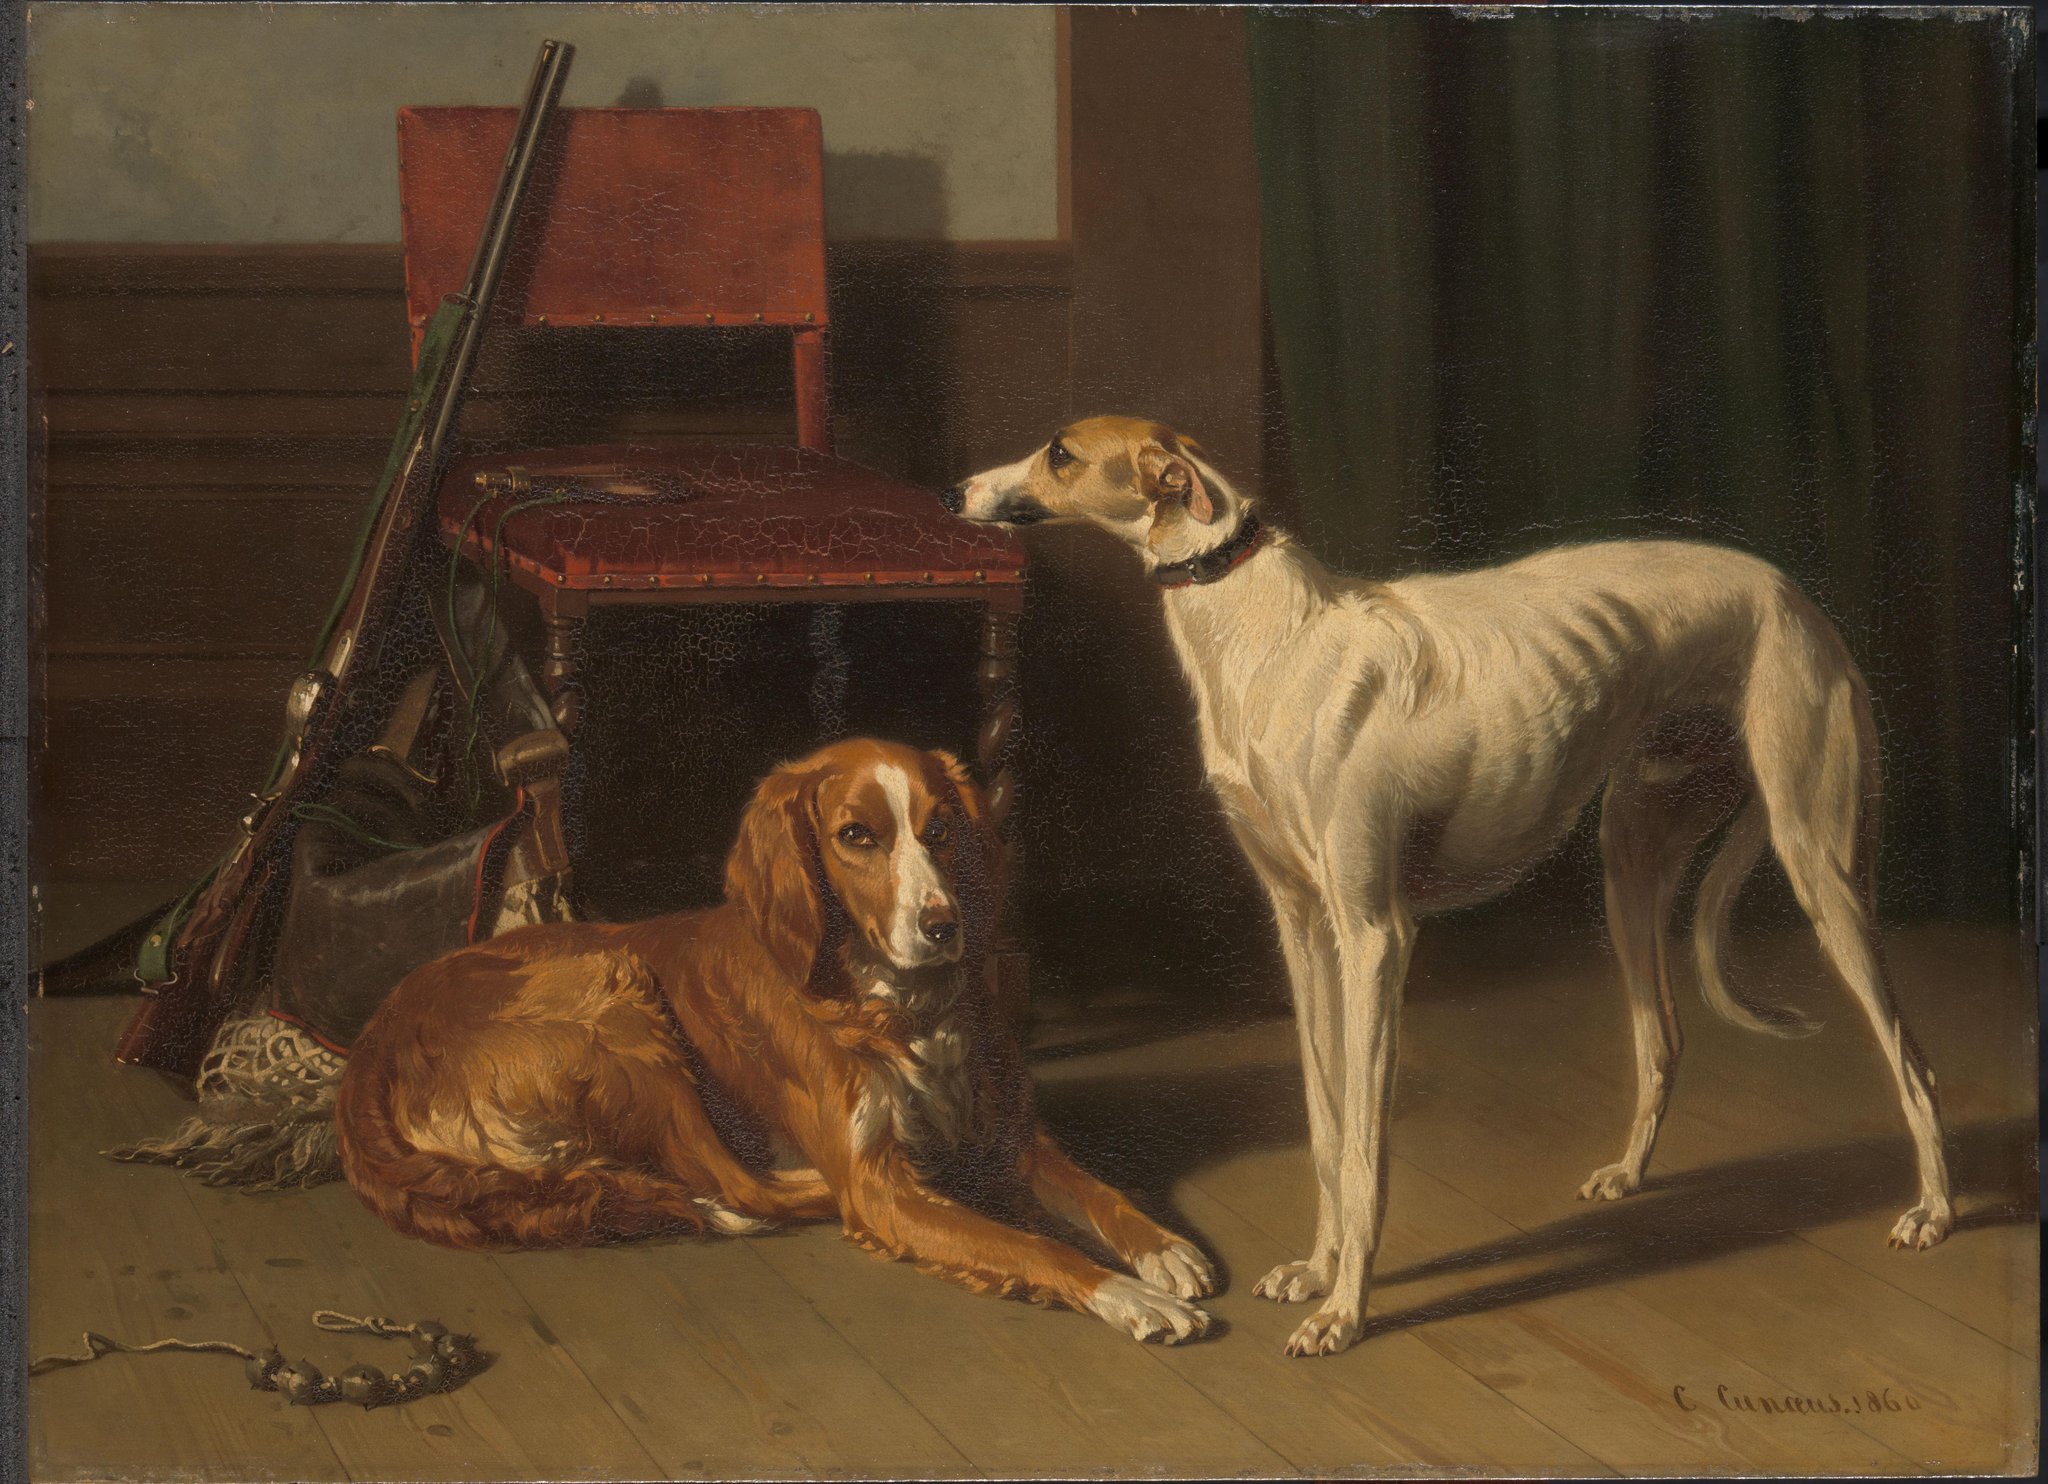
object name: painting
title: Hunting Companions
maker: conradijn cunaeus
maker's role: draughtsman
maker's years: 1828-1895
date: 1860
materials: oil, panel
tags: hunting dogs, dog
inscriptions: signature and date: ‘C Cunaeus. 1860’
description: Jachtgezellen: twee jachthonden bij een stoel waartegen een jachtgeweer en weitas staan.